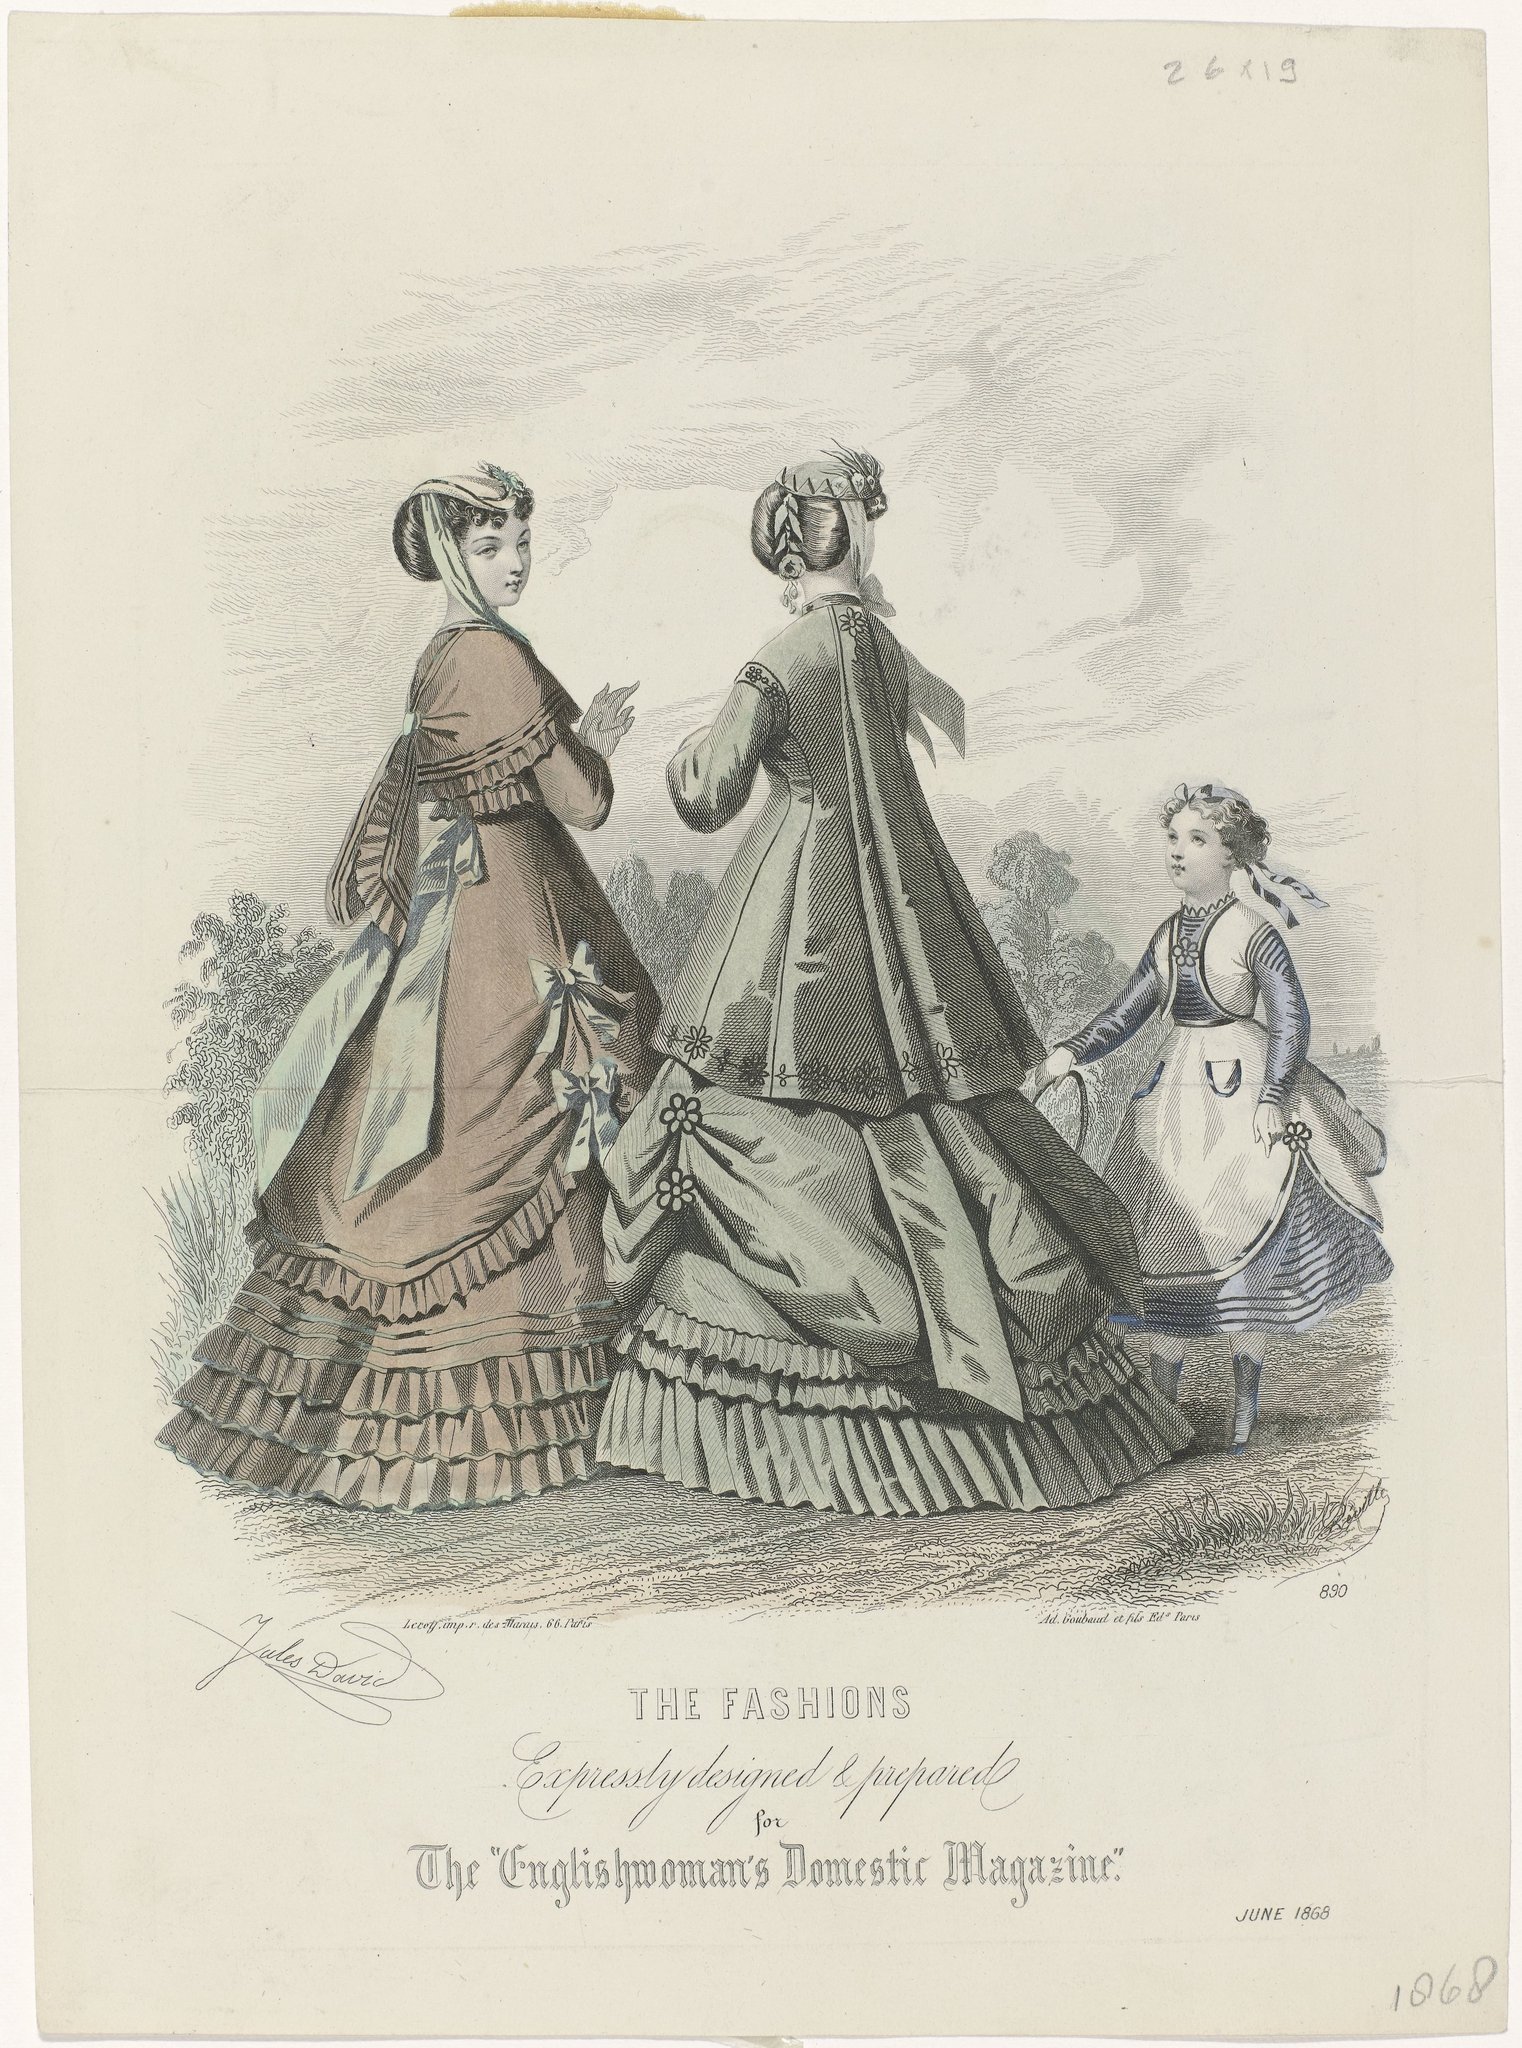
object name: fashion print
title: The Englishwoman's Domestic Magazine, June 1868, No. 890 : The Fashions (...)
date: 1868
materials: paper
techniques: engraving, hand coloring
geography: paris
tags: bow (ornamental part of clothing) (+ women's clothes), head-gear: hat (+ girls' clothes), coat (+ women's clothes), fashion plates, head-gear: hat (+ women's clothes), skirt (+ women's clothes), (bowling a) hoop, dress, gown (+ girls' clothes)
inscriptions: title: ‘THE FASHIONS / Expressly designed & prepared / for / The "Englishwoman's Domestic Magazine."’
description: Twee vrouwen, op de rug gezien. Links: japon versierd met strikken en afgezet met ruches. Bijpassende kleine schoudermantel(?). Rechts: korte mantel met bloemmotief en platte plooien op de rug. Kleine hoeden met striklinten. Naast hun staat een meisje met hoepel in de hand. Zij draagt een japon met strepenmotief, waarop een bolero en overrok met zakjes. Prent uit het modetijdschrift The Englishwoman's Domestic Magazine (Londen 1852-1877).